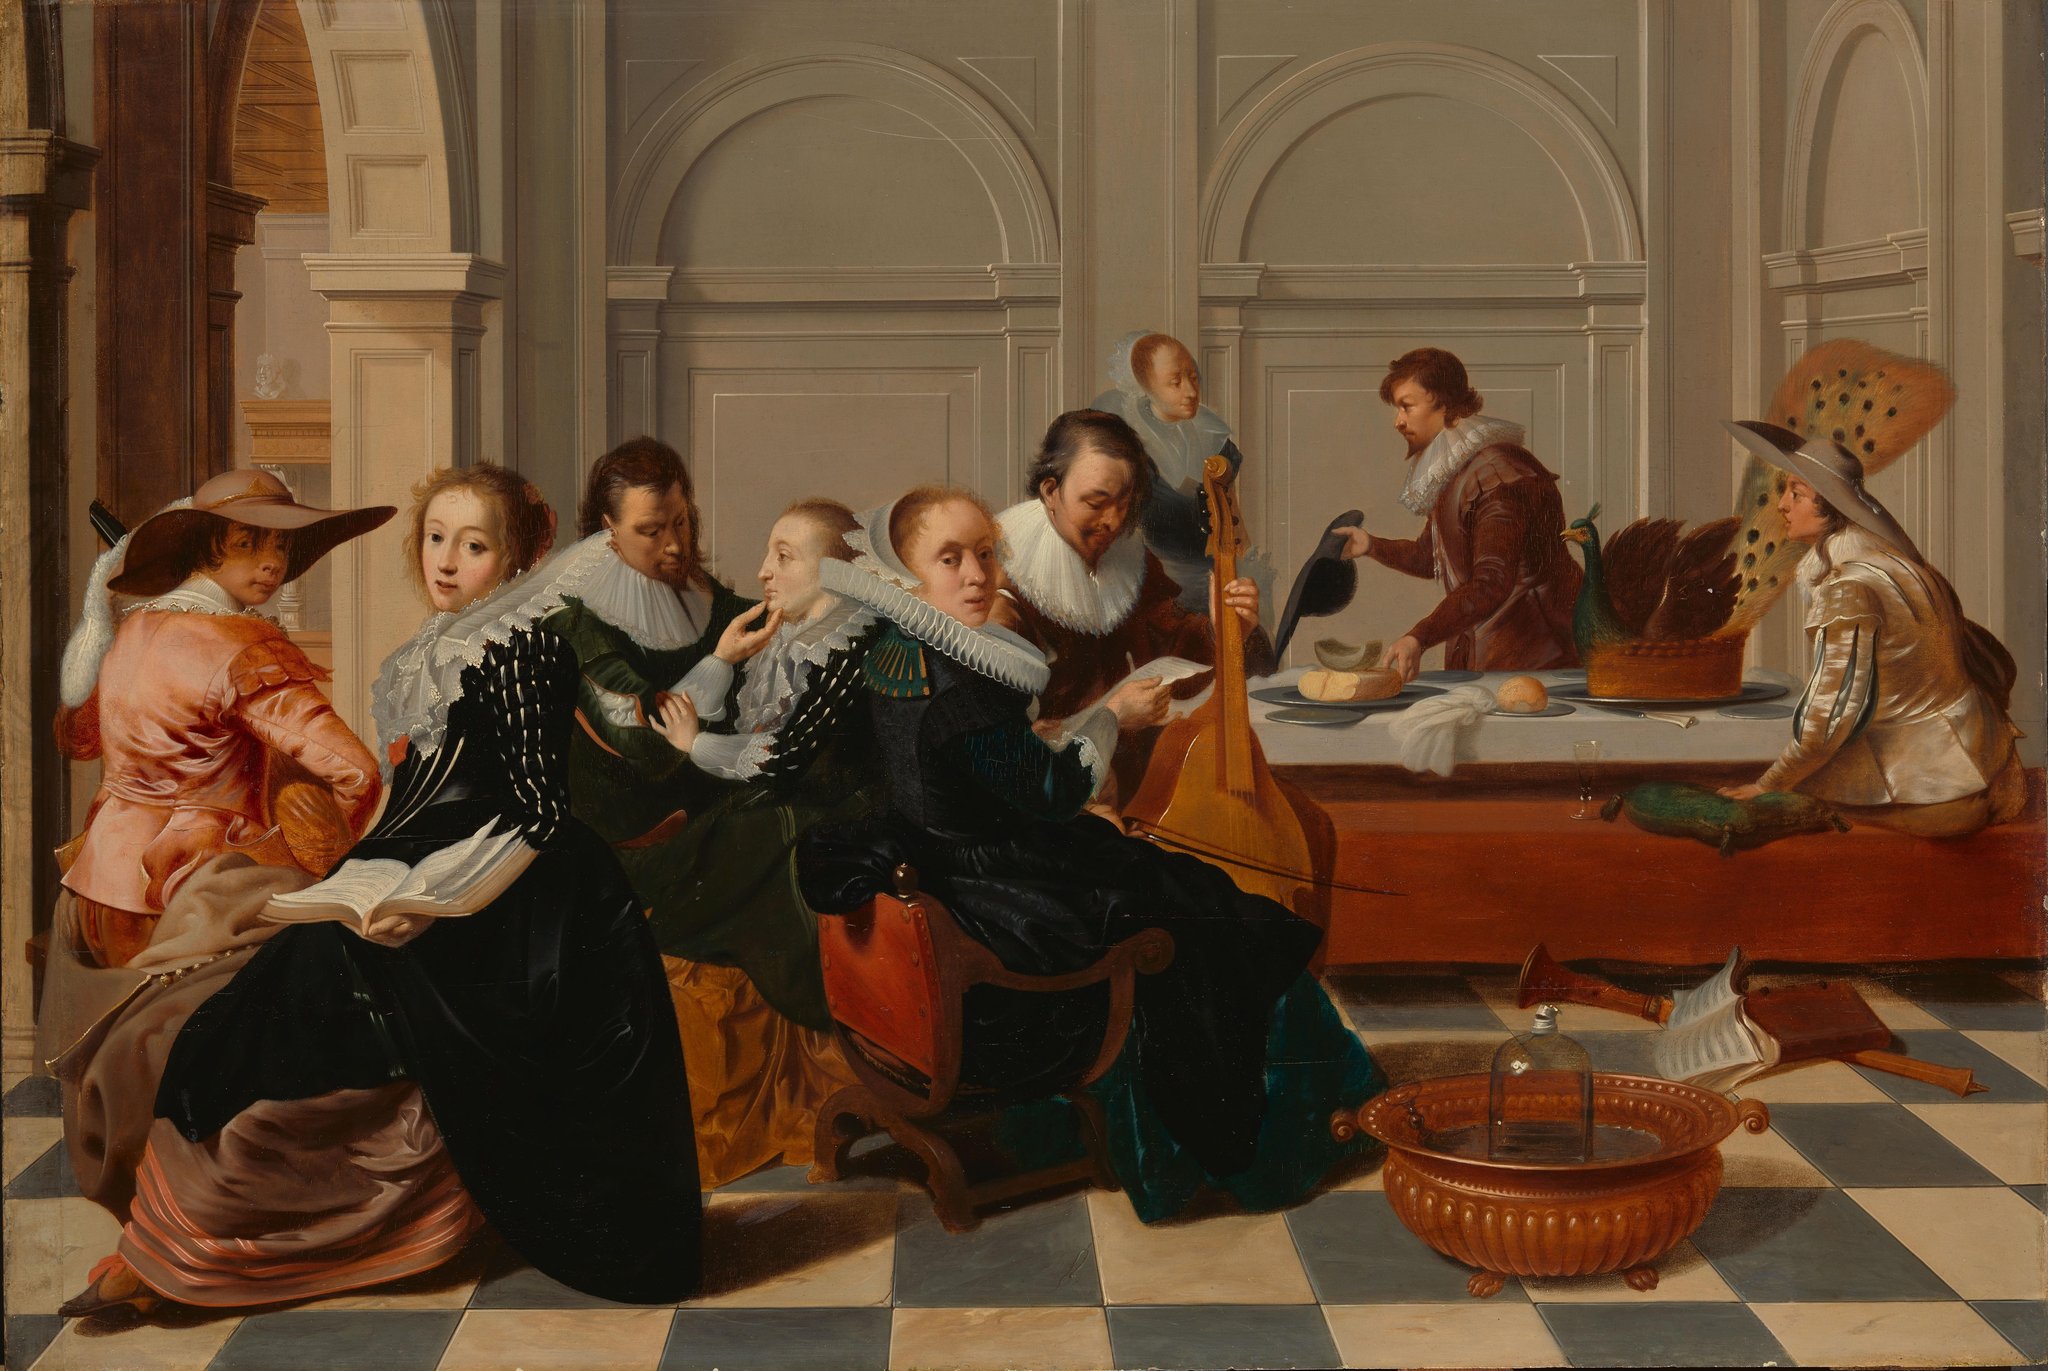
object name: painting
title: The Musical Gathering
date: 1700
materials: oil, panel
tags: small group of musicians, chamber orchestra, jazz band, viola, violoncello; double bass, musician(s) accompanying singer(s), clarinet, bassoon, oboe, shawm, printed edition of musical score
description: Een muziekpartij of concert. Interieur met een elegant gezelschap. Links een jongen met een luit en een vrouw met een liedboek, rechts een man met een viola da gamba en een vrouw met een blad papier in de handen. Waarschijnlijk zijn de vrouwen aan het zingen. Hiertussen een minnekozend paar. Op de voorgrond op de vloer een grote metalen koeler met een fles wijn en een glas, daarachter een schalmei met bladmuziek. Op de achtergrond een tafel met een pauwenpastei , kaas en brood.